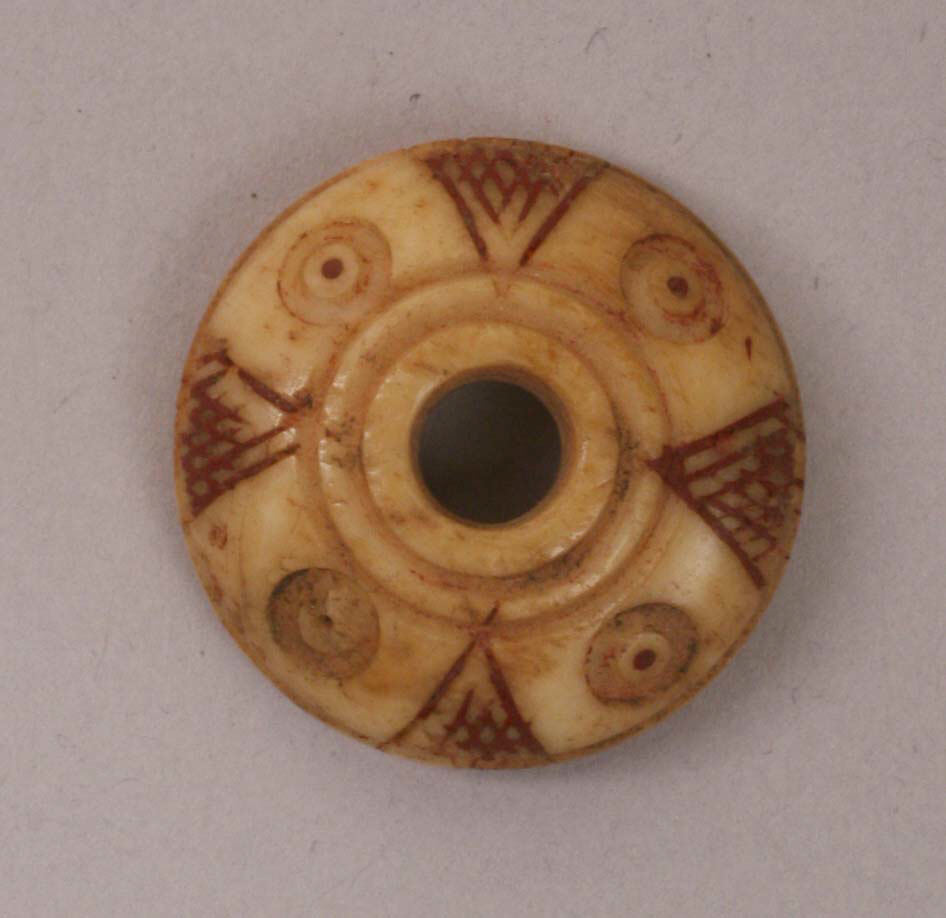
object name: button or spindle whorl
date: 201-700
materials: bone, paint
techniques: incising, inlay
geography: egypt